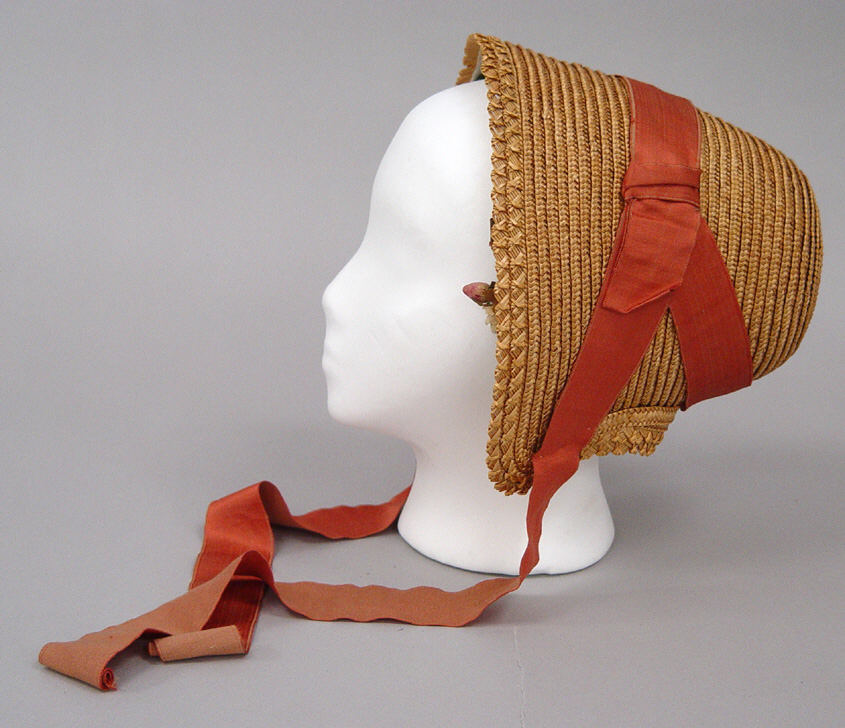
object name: bonnet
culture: american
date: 1844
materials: silk, fiber